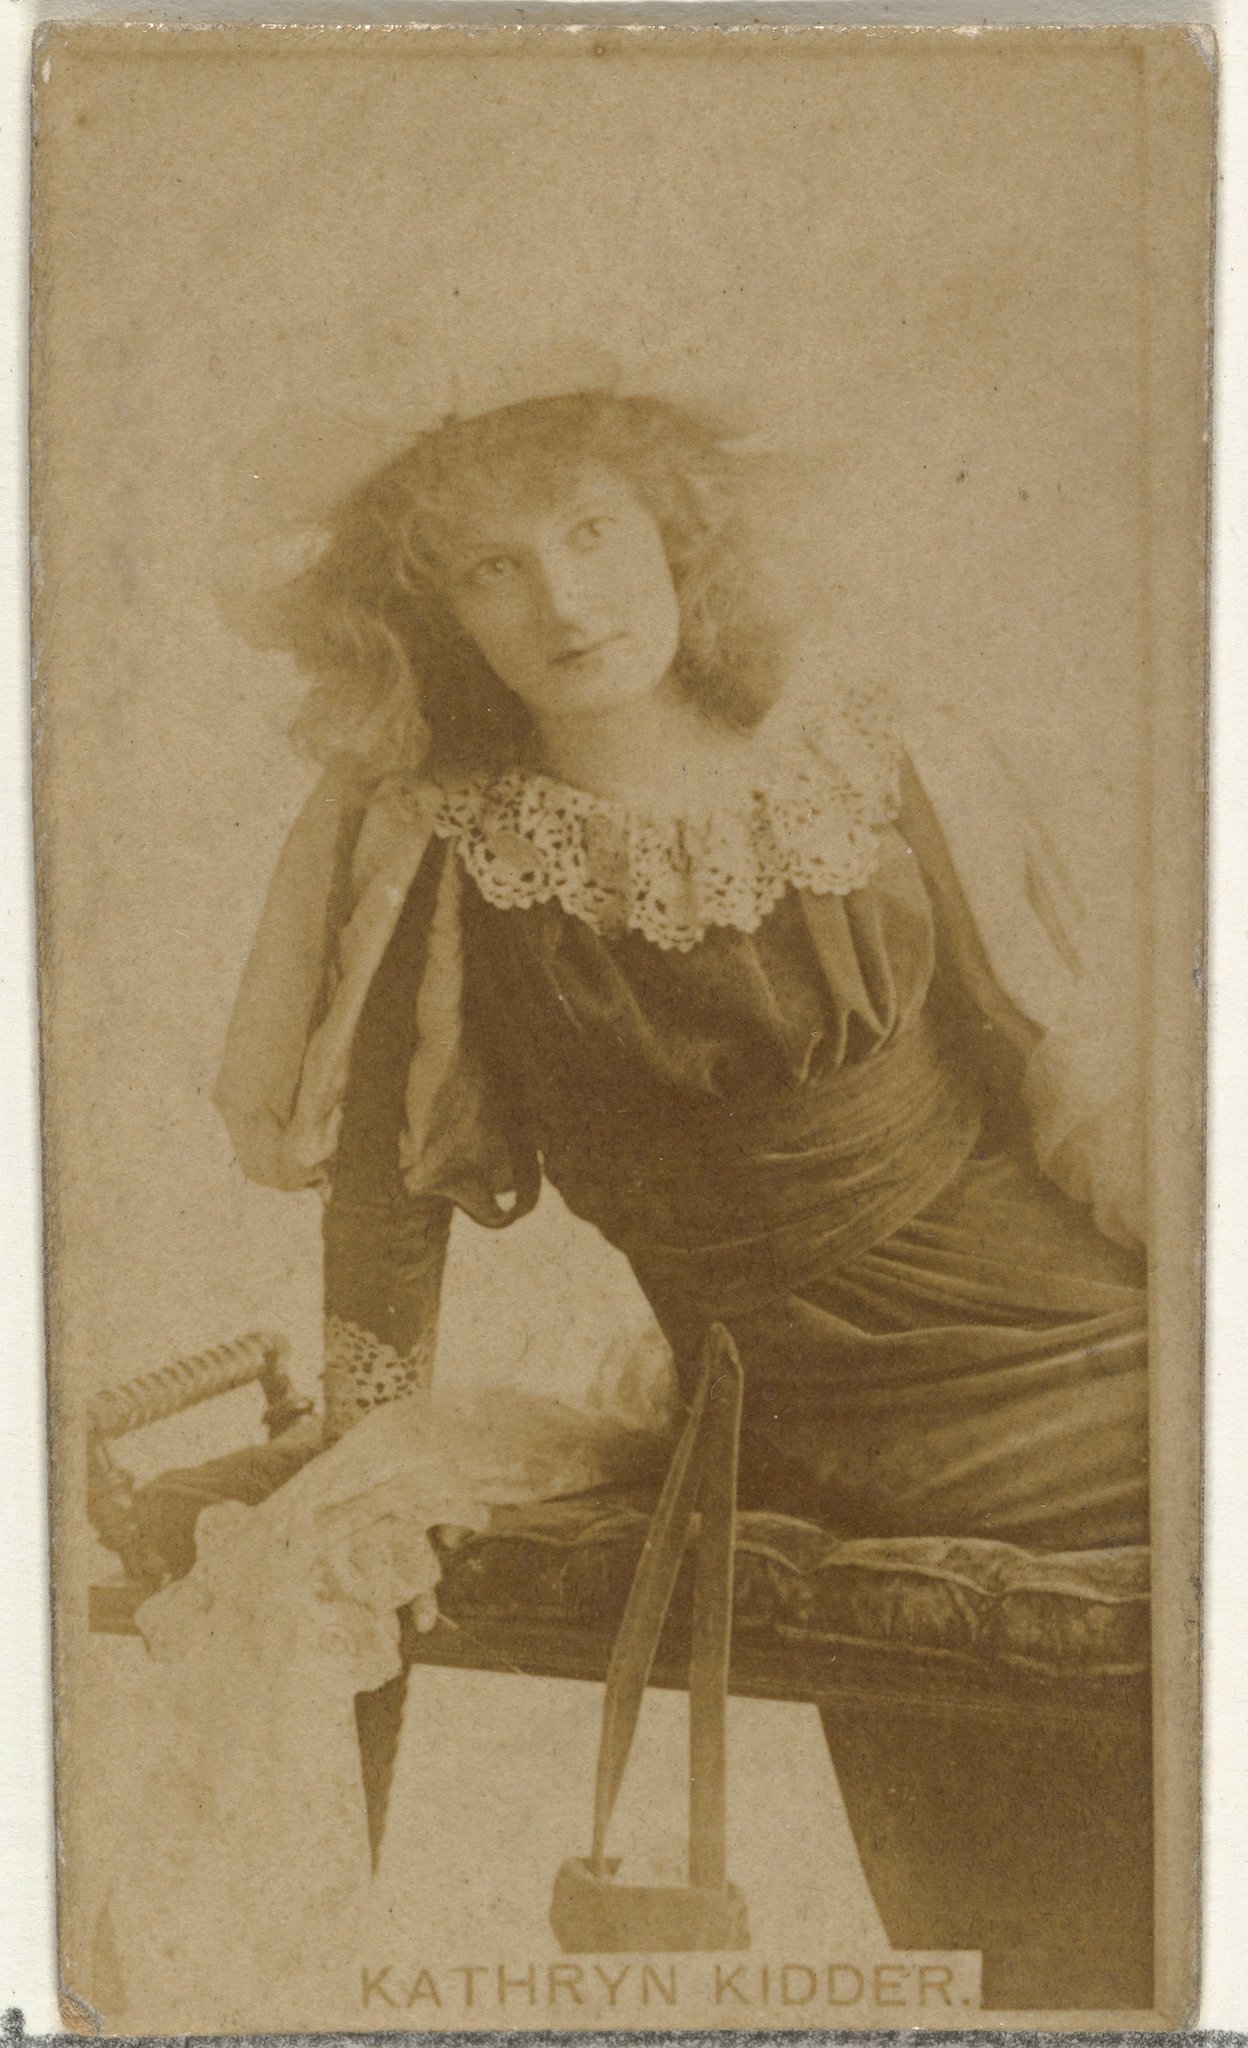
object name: photograph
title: Kathryn Kidder, from the Actors and Actresses series (N145-8) issued by Duke Sons & Co. to promote Duke Cigarettes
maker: w. duke, sons & co.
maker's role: publisher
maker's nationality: american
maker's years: 1870-1920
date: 1891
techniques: albumen silver print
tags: portraits,women,actresses